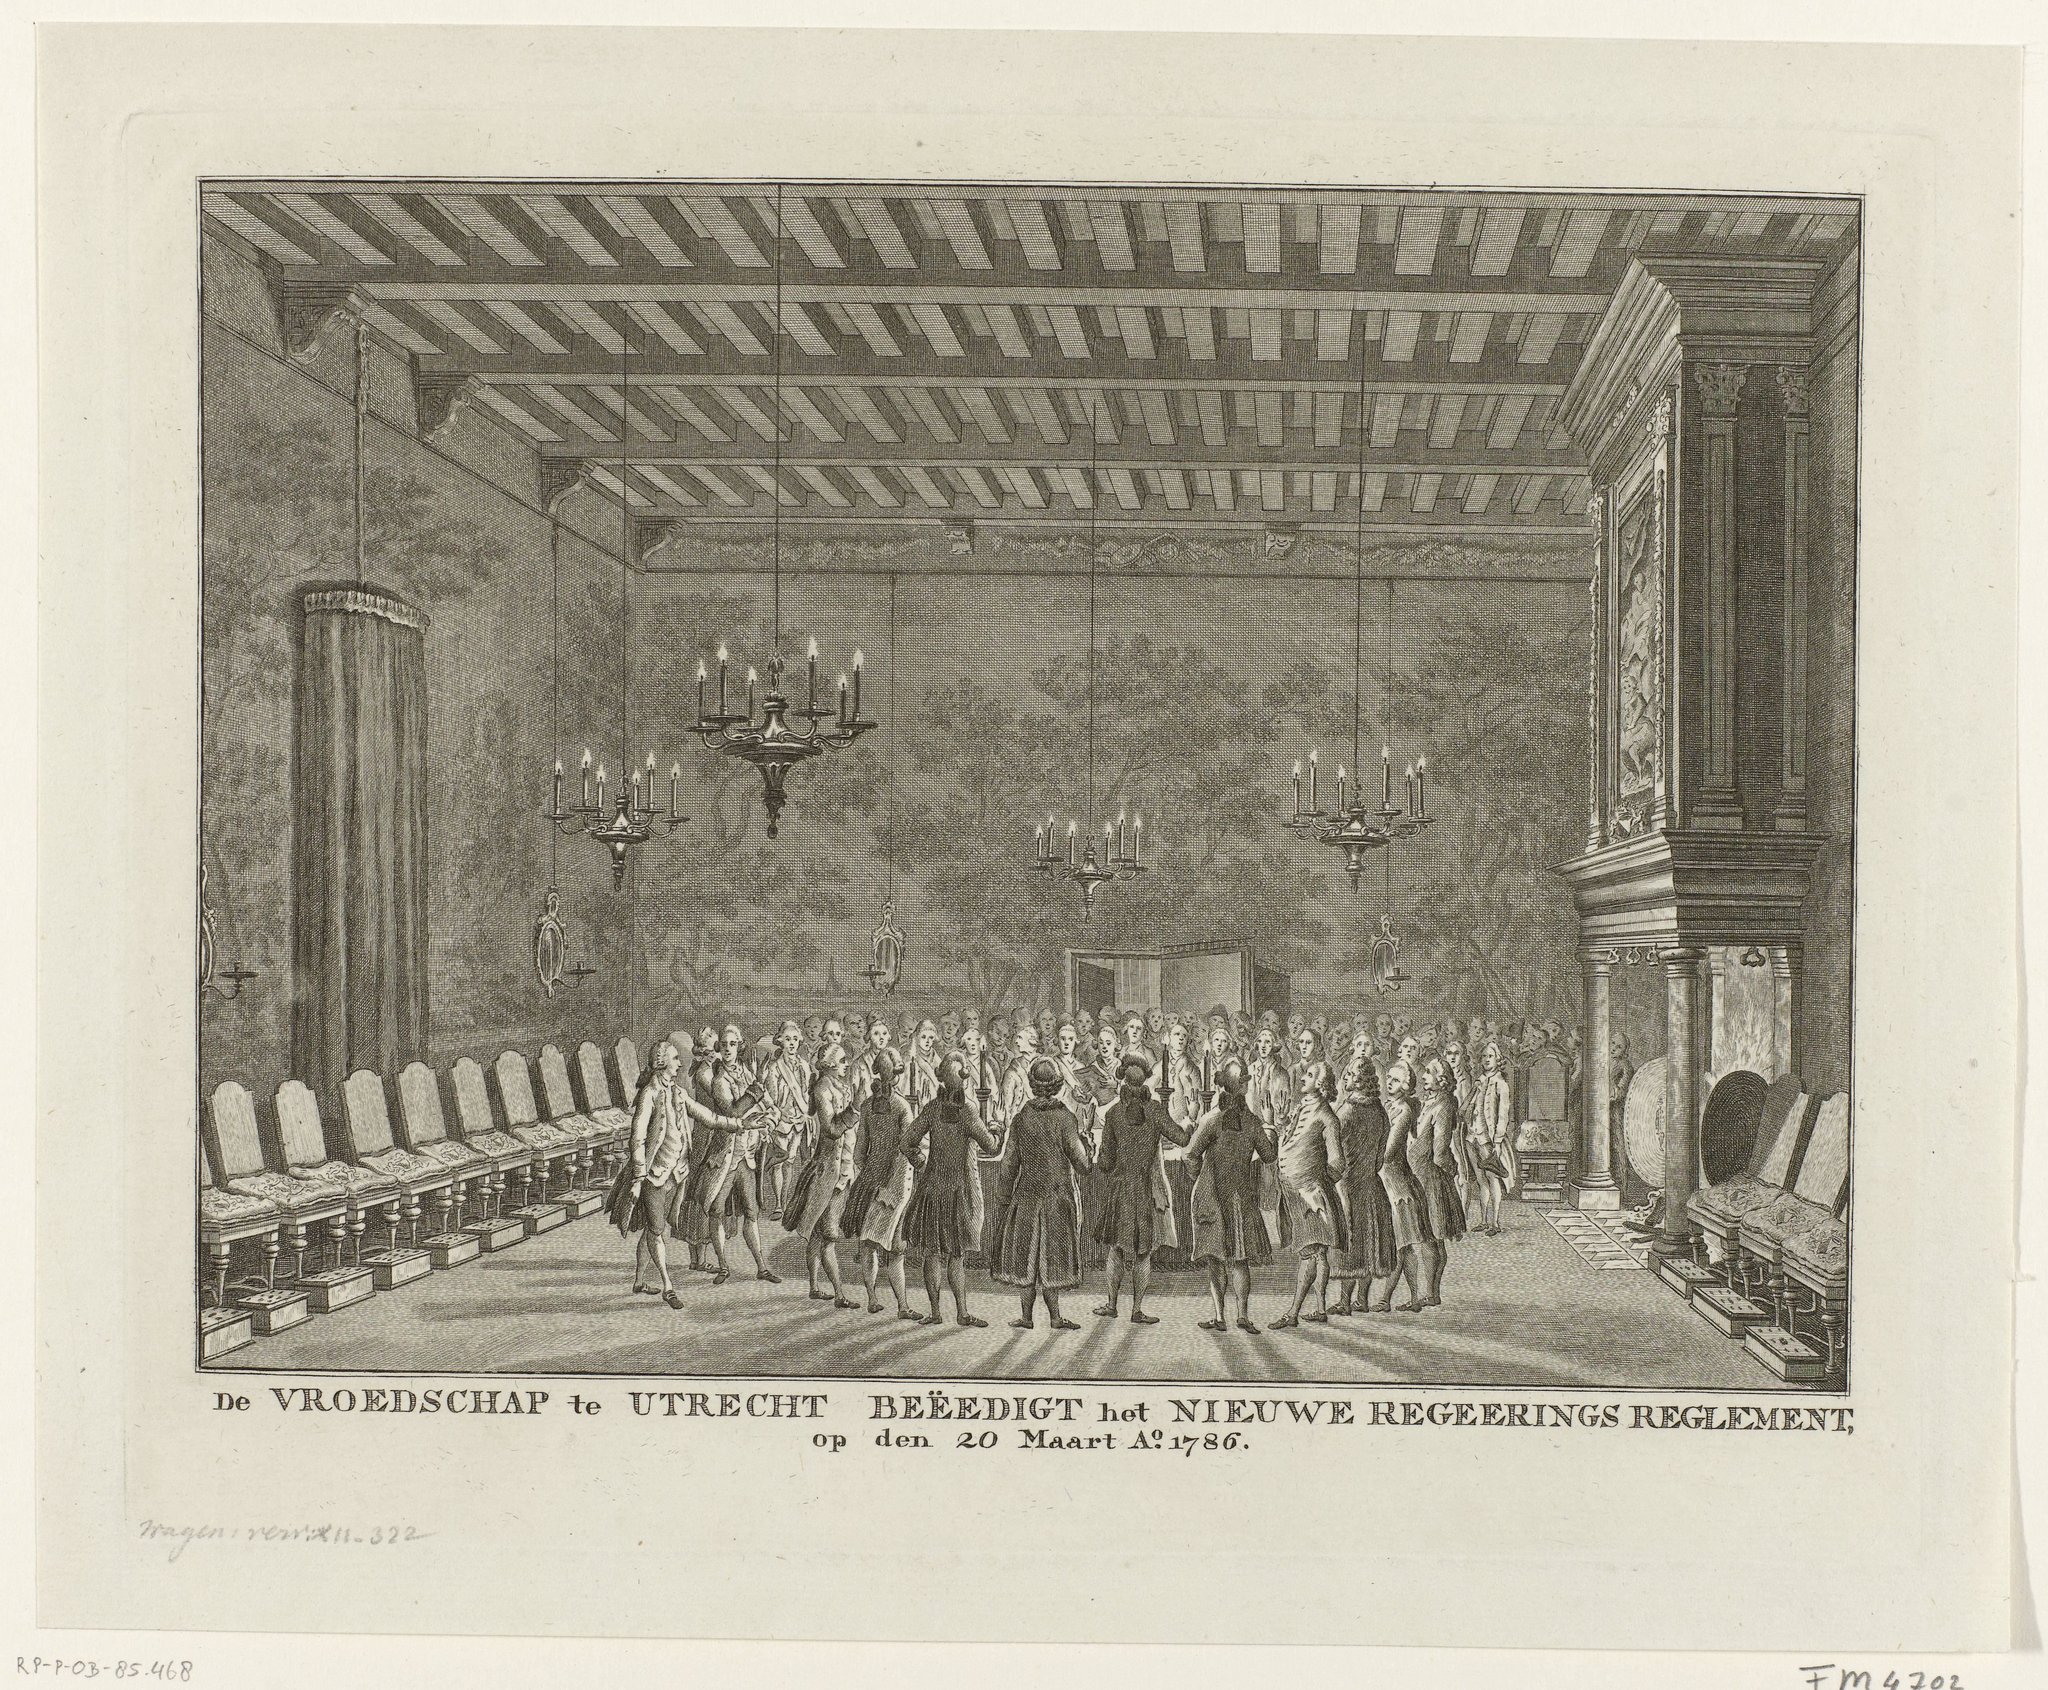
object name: print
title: De vroedschap te Utrecht beëdigt het nieuwe regeerings reglement, op den 20 Maart Ao. 1786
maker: carel frederik bendorp (i)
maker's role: print maker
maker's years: 1736-1814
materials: paper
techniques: engraving, etching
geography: northern netherlands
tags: city council, swearing an oath (with two fingers raised), patriots (1780-1795)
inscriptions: collector's mark: Lugt 2228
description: De leden van de vroedschap van Utrecht leggen de eed af op het nieuwe regeringsreglement, in het stadhuis van Utrecht, 20 maart 1786. Interieur met de leden opgesteld in een kring rond een tafel.